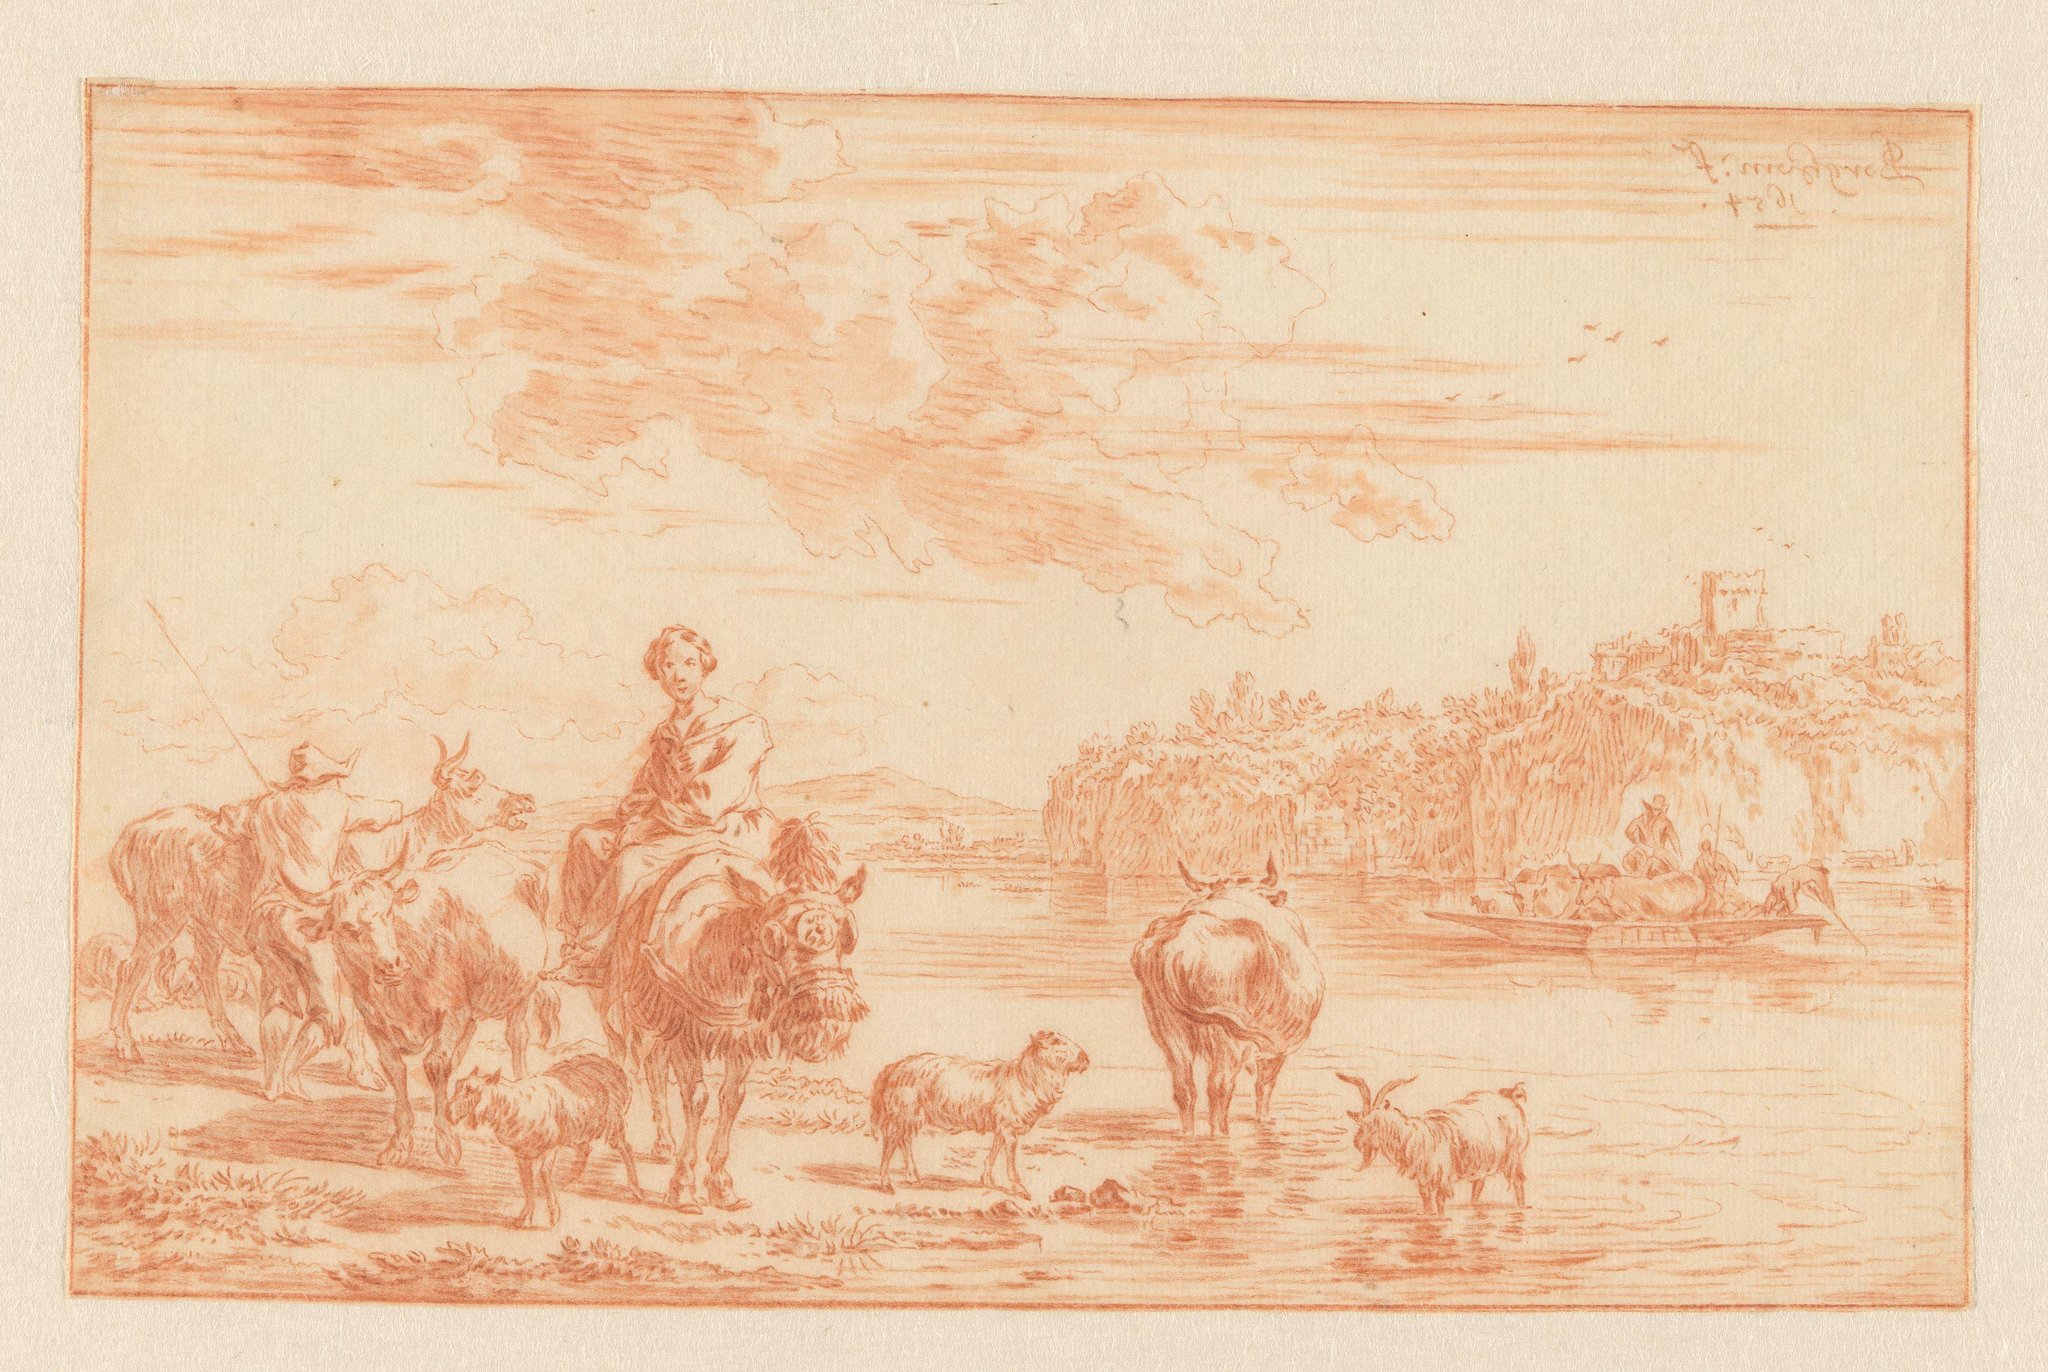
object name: drawing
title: Vrouw op muilezel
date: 1769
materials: chalk, paper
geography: amsterdam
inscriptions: collector's mark: ‘RIJKS/ MUSM’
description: Doordruktekening in rood krijt voor de prent RP-P-1939-1297